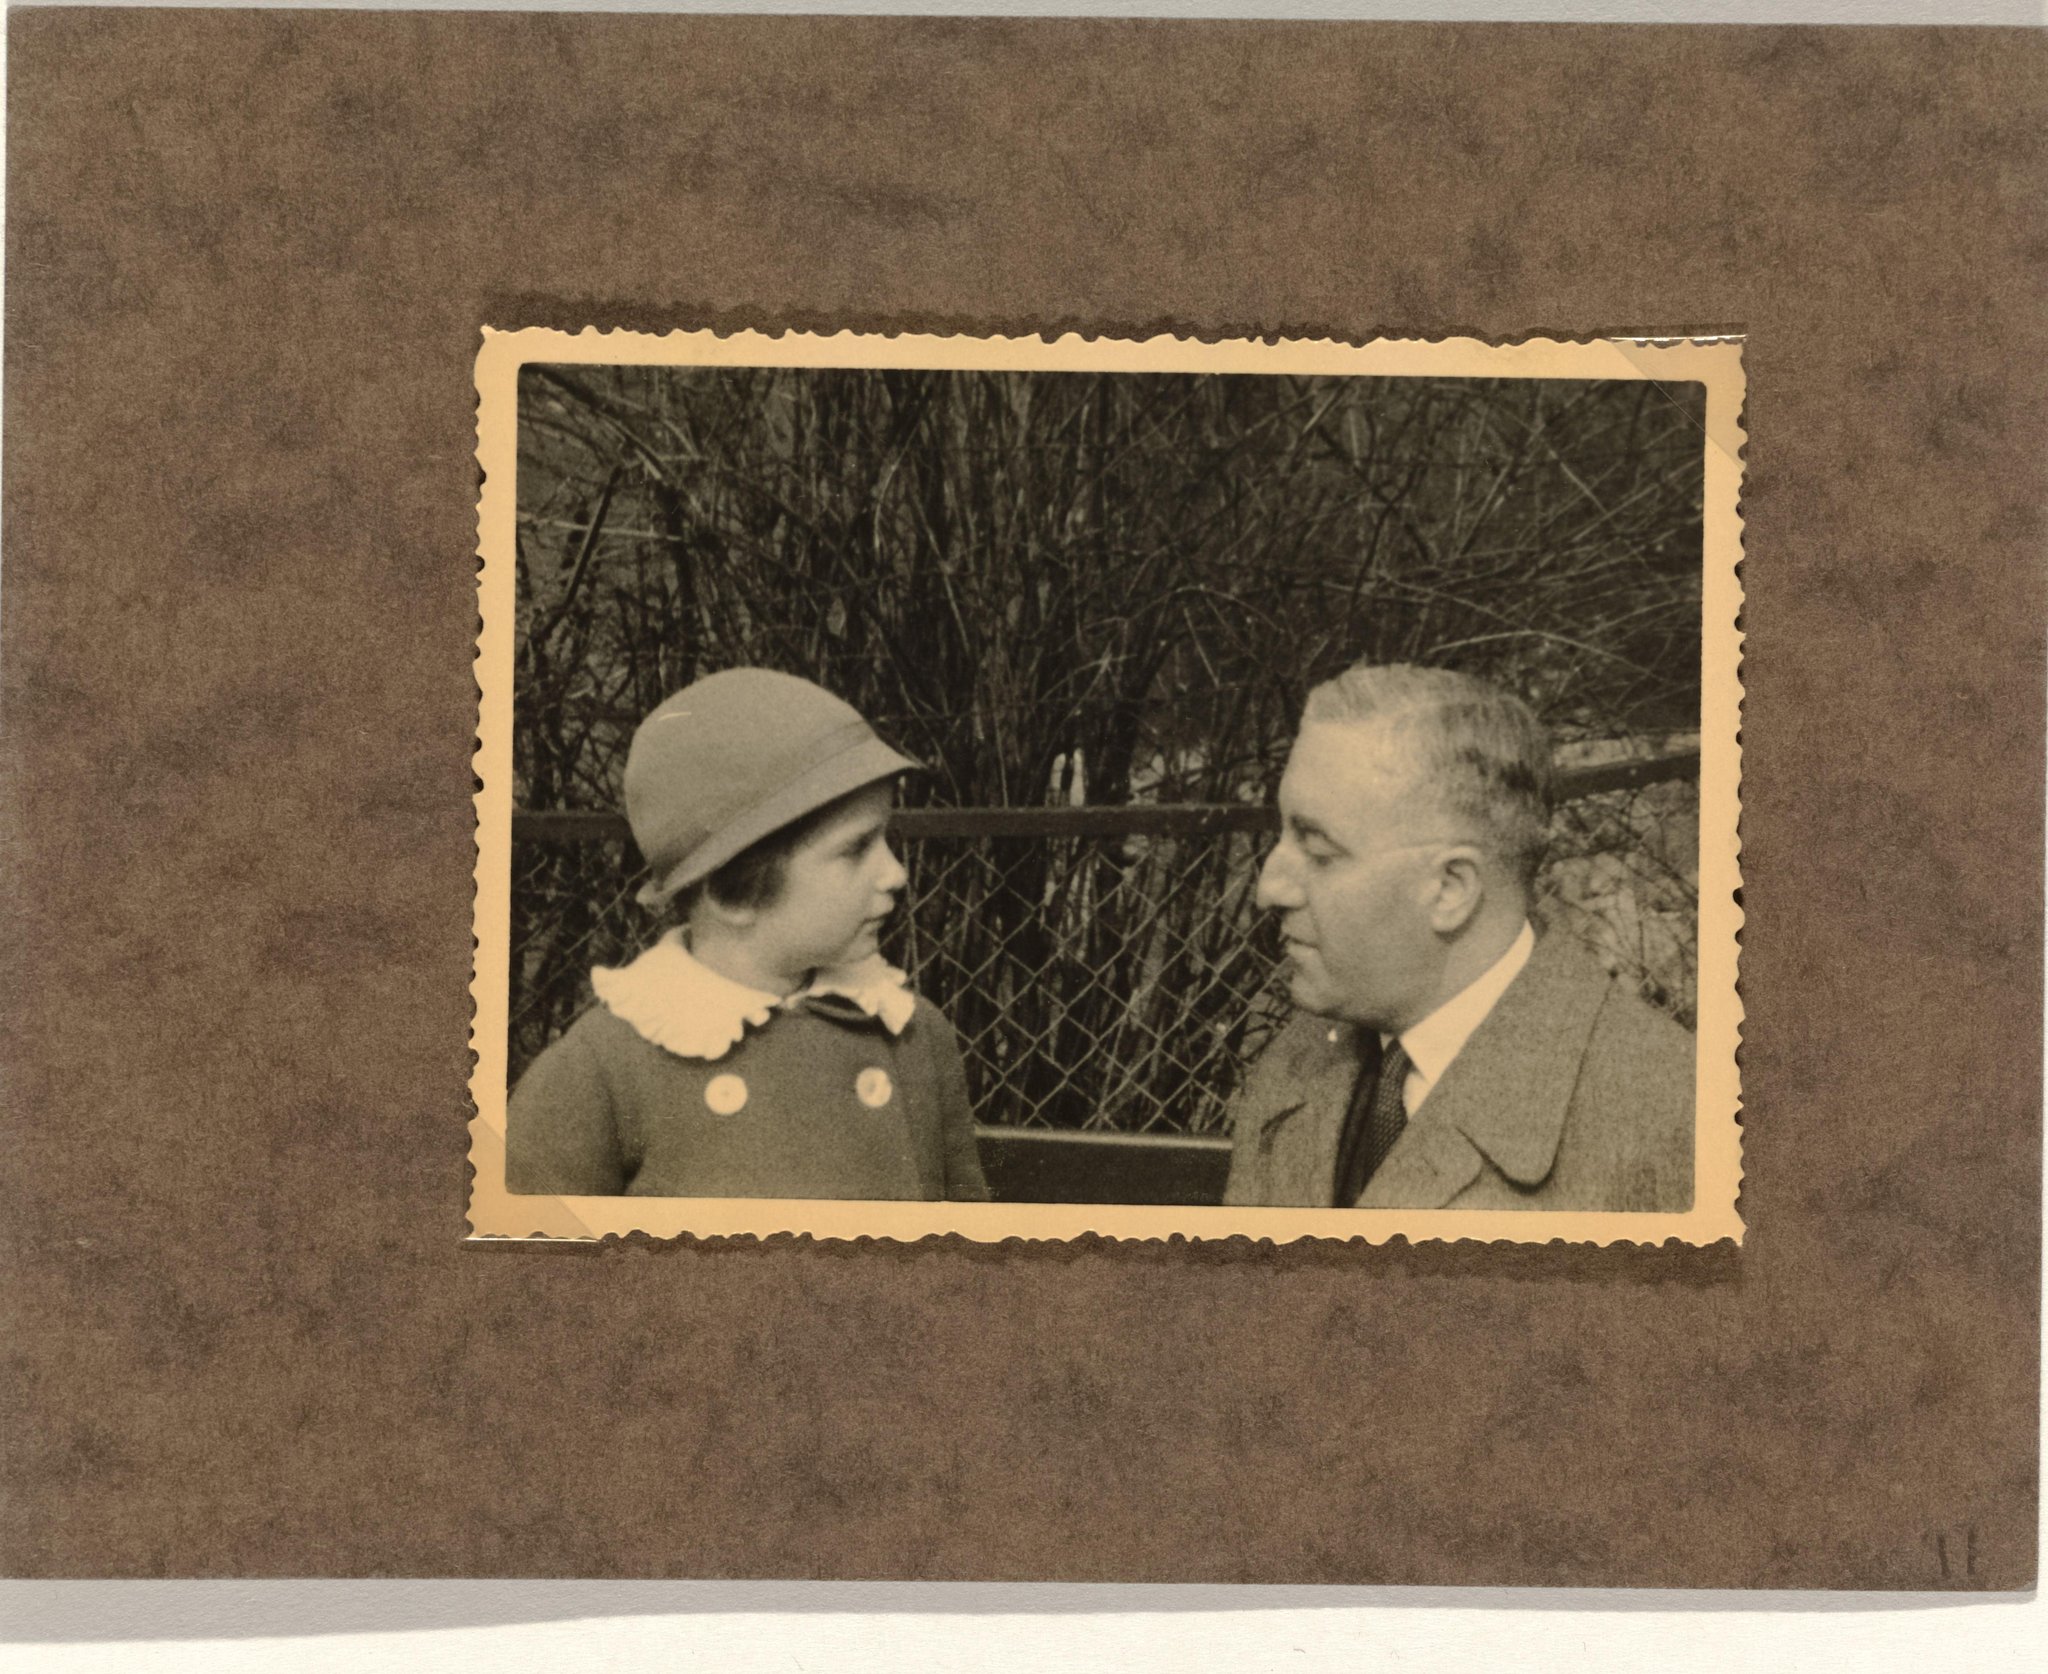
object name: photograph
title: Isabel Wachenheimer (links) en haar vader Eugen Wachenheimer (rechts) bij een rivier in Hamburg tijdens een bezoek aan Willy Moos, september 1934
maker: Anonymous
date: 1909-1934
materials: photographic support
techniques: gelatin silver print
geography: hamburg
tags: eugen wachenheimer, leiden, isabel wachenheimer-elon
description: Isabel Wachenheimer (links) en haar vader Eugen Wachenheimer (rechts) voor een hek en struiken in Hamburg.